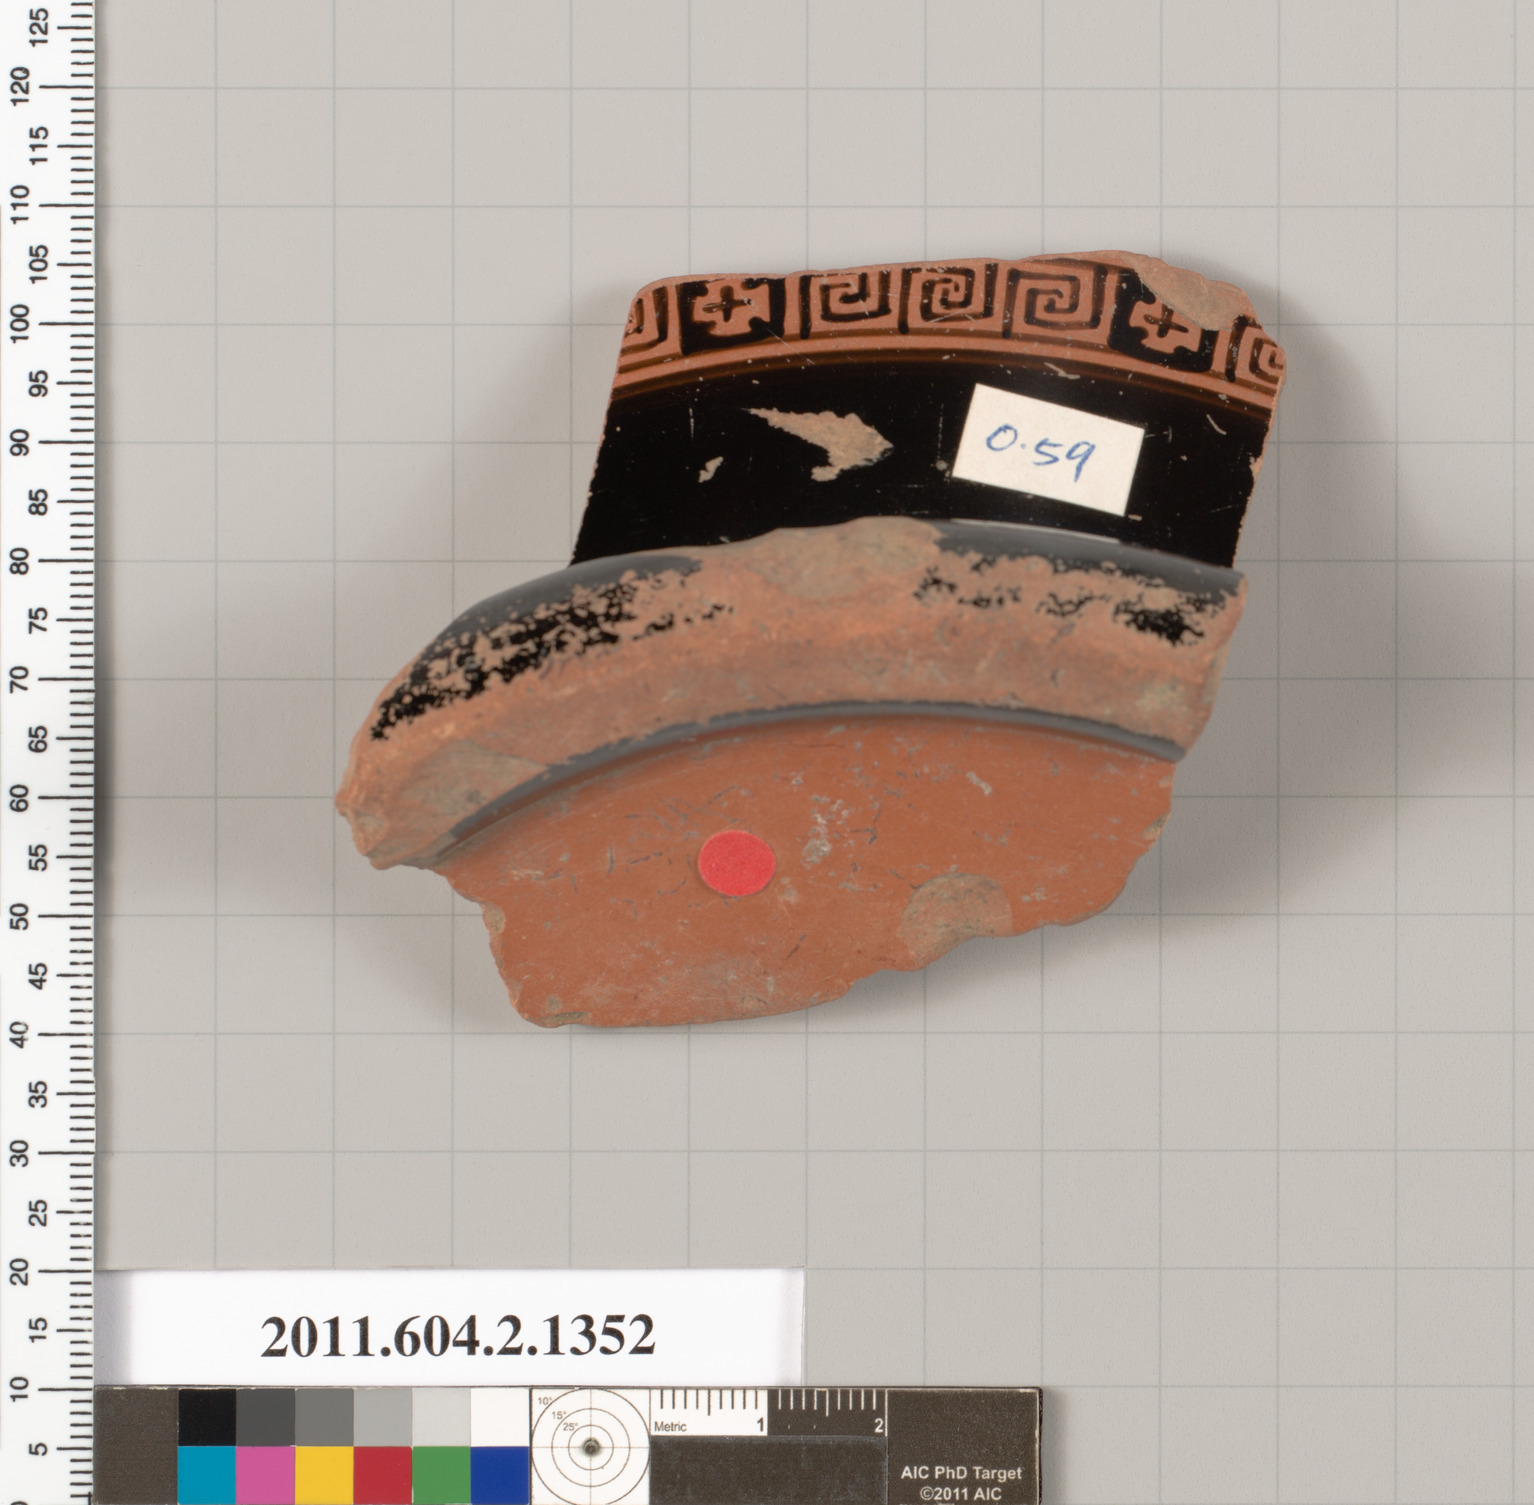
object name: skyphos fragment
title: Terracotta fragment of a skyphos (deep drinking cup)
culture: greek, attic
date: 475-451 BCE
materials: terracotta